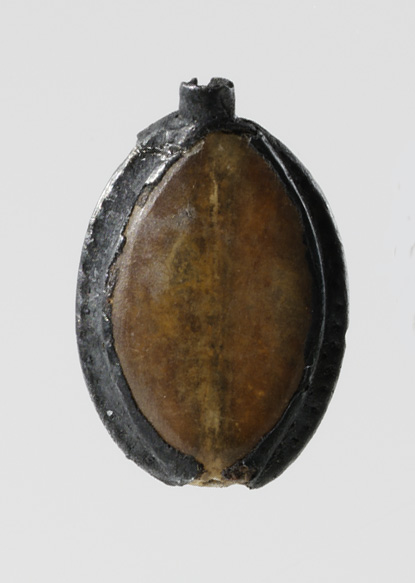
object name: bead, cowroid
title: Cowroid bead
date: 1550-1425 BCE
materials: silver, stone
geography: egypt